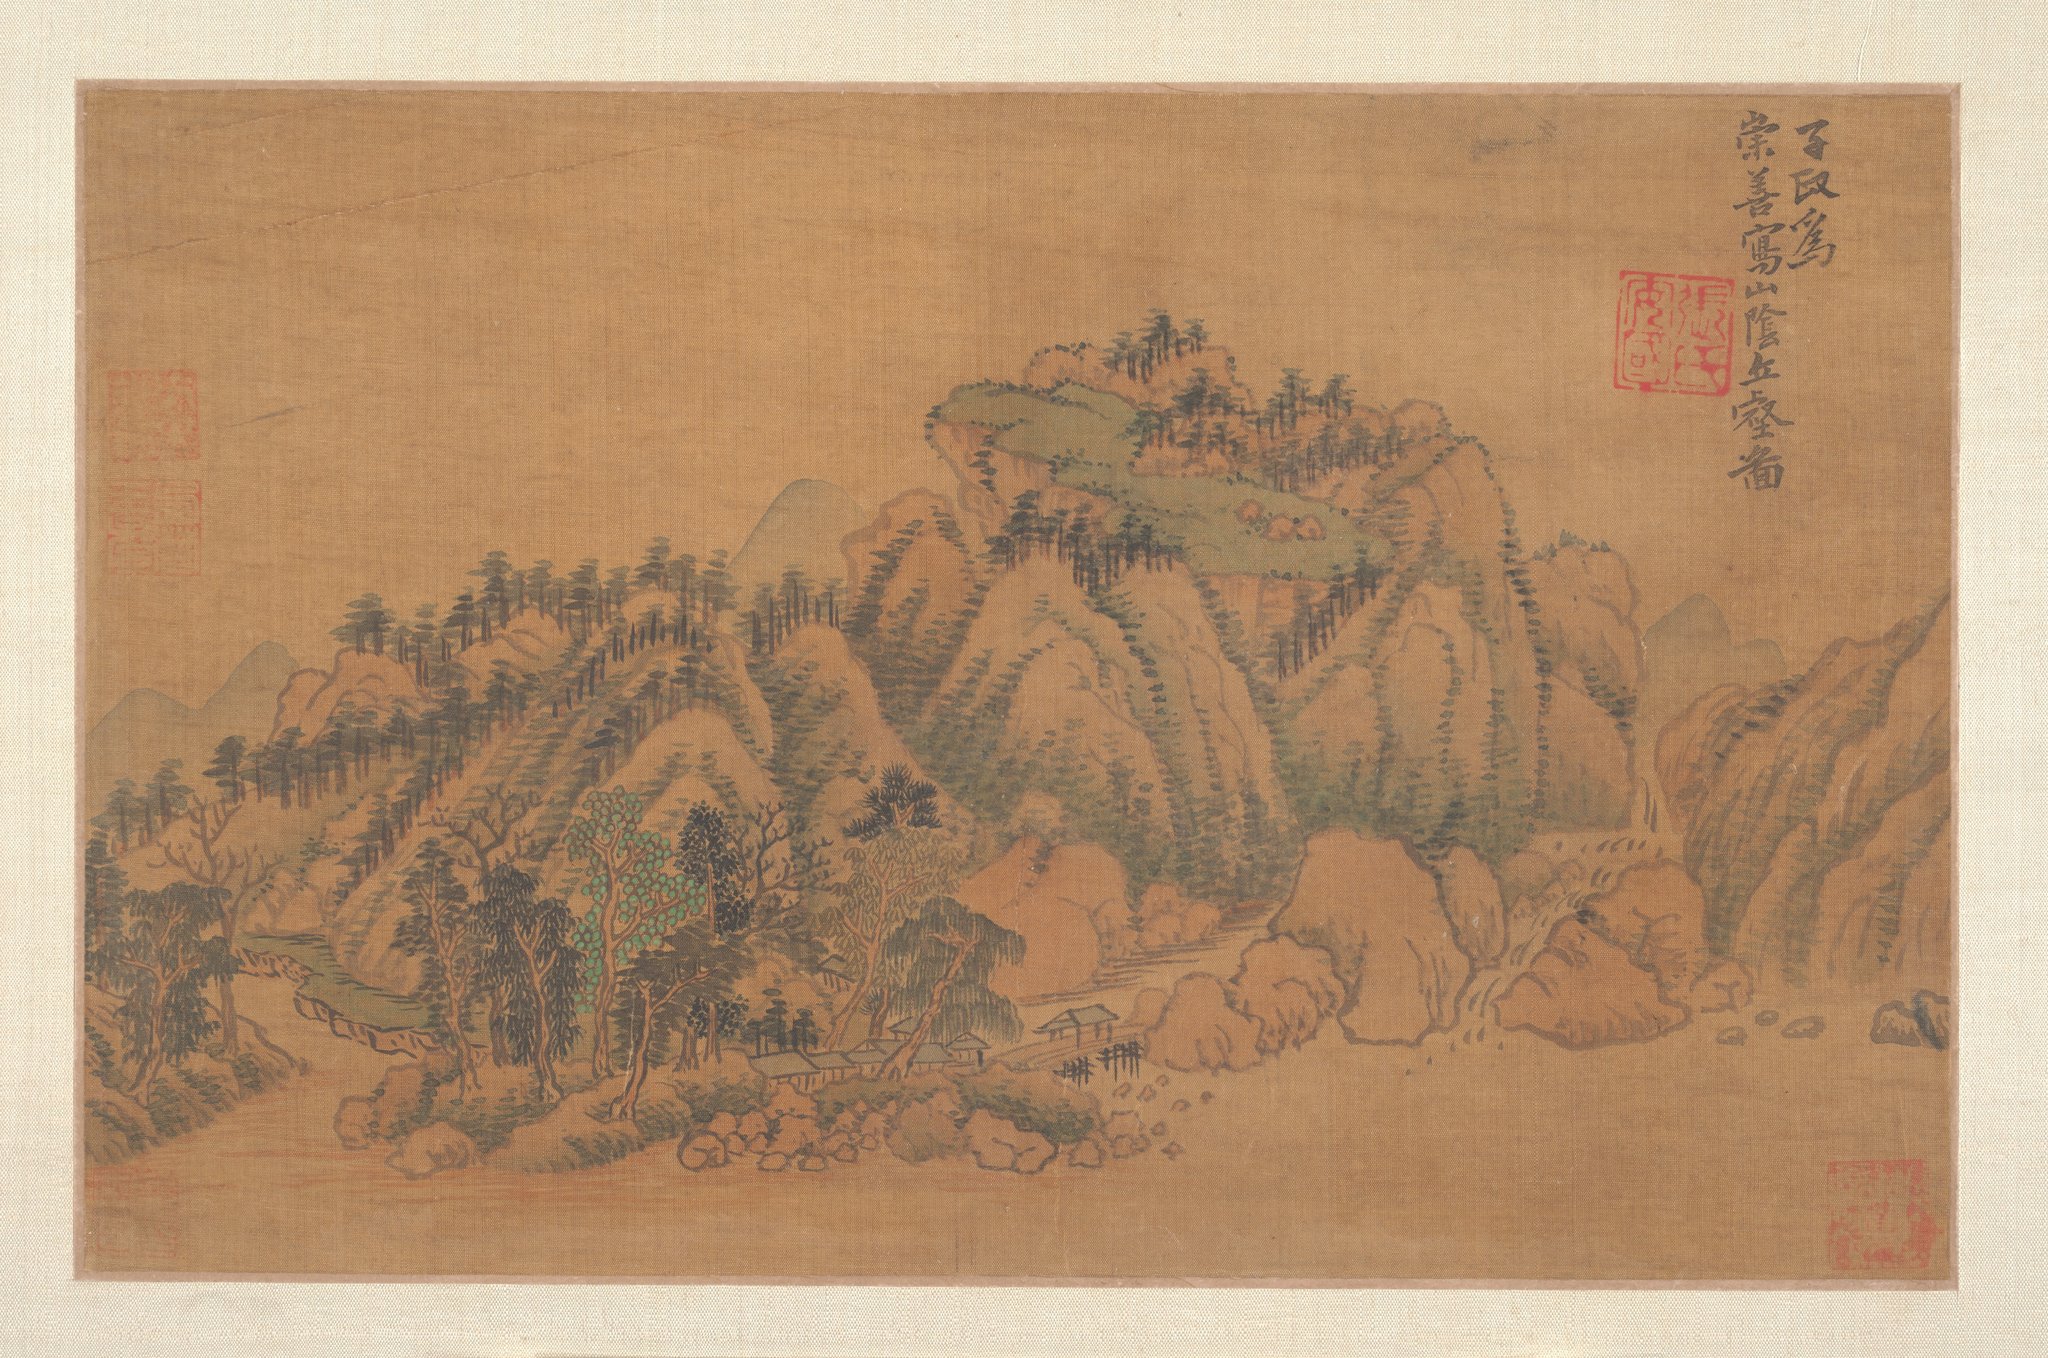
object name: album leaf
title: Landscape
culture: chinese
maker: unidentified artist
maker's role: artist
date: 1644-1911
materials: ink, silk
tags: mountains,landscapes